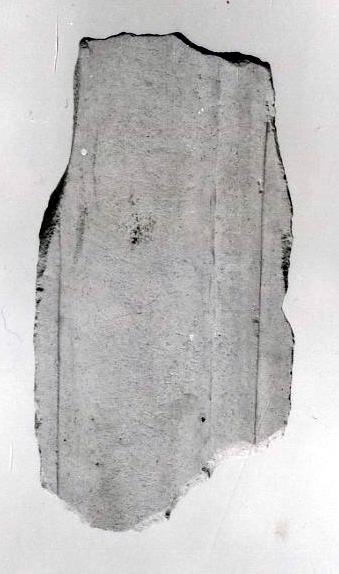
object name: relief fragment, tomb of meketre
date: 1981-1975 BCE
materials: limestone, paint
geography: egypt